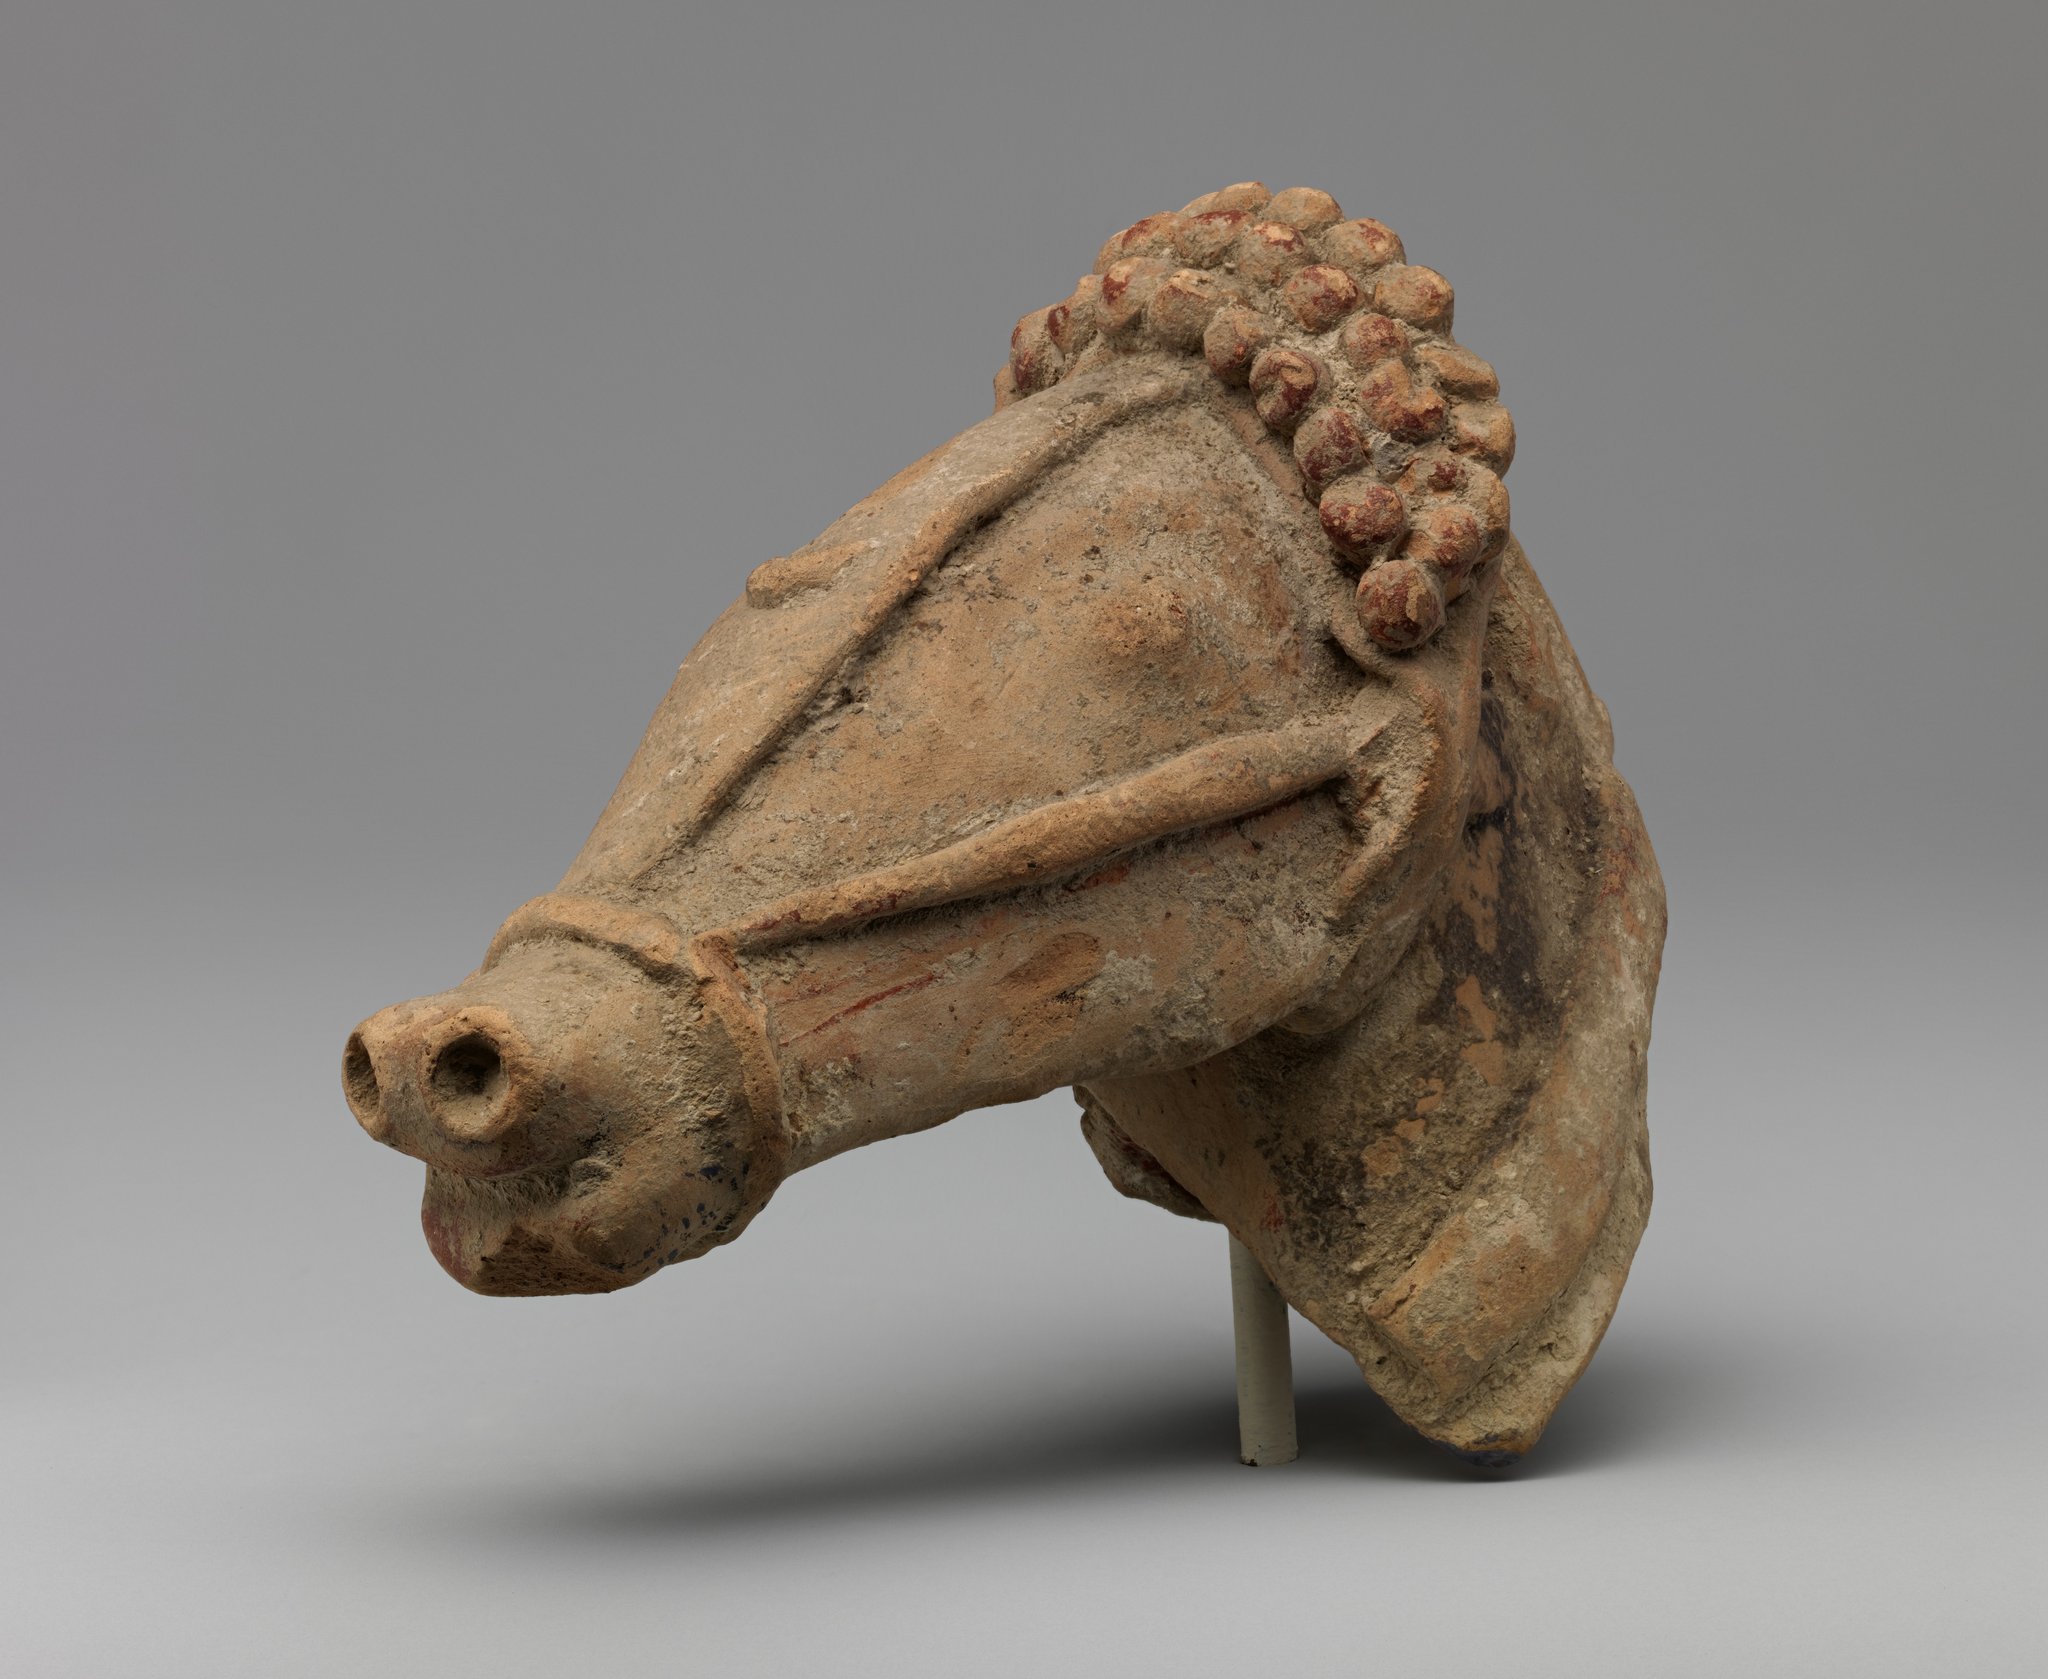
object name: head of a horse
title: Terracotta horse's head with harness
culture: cypriot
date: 600-480 BCE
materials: terracotta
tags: horses